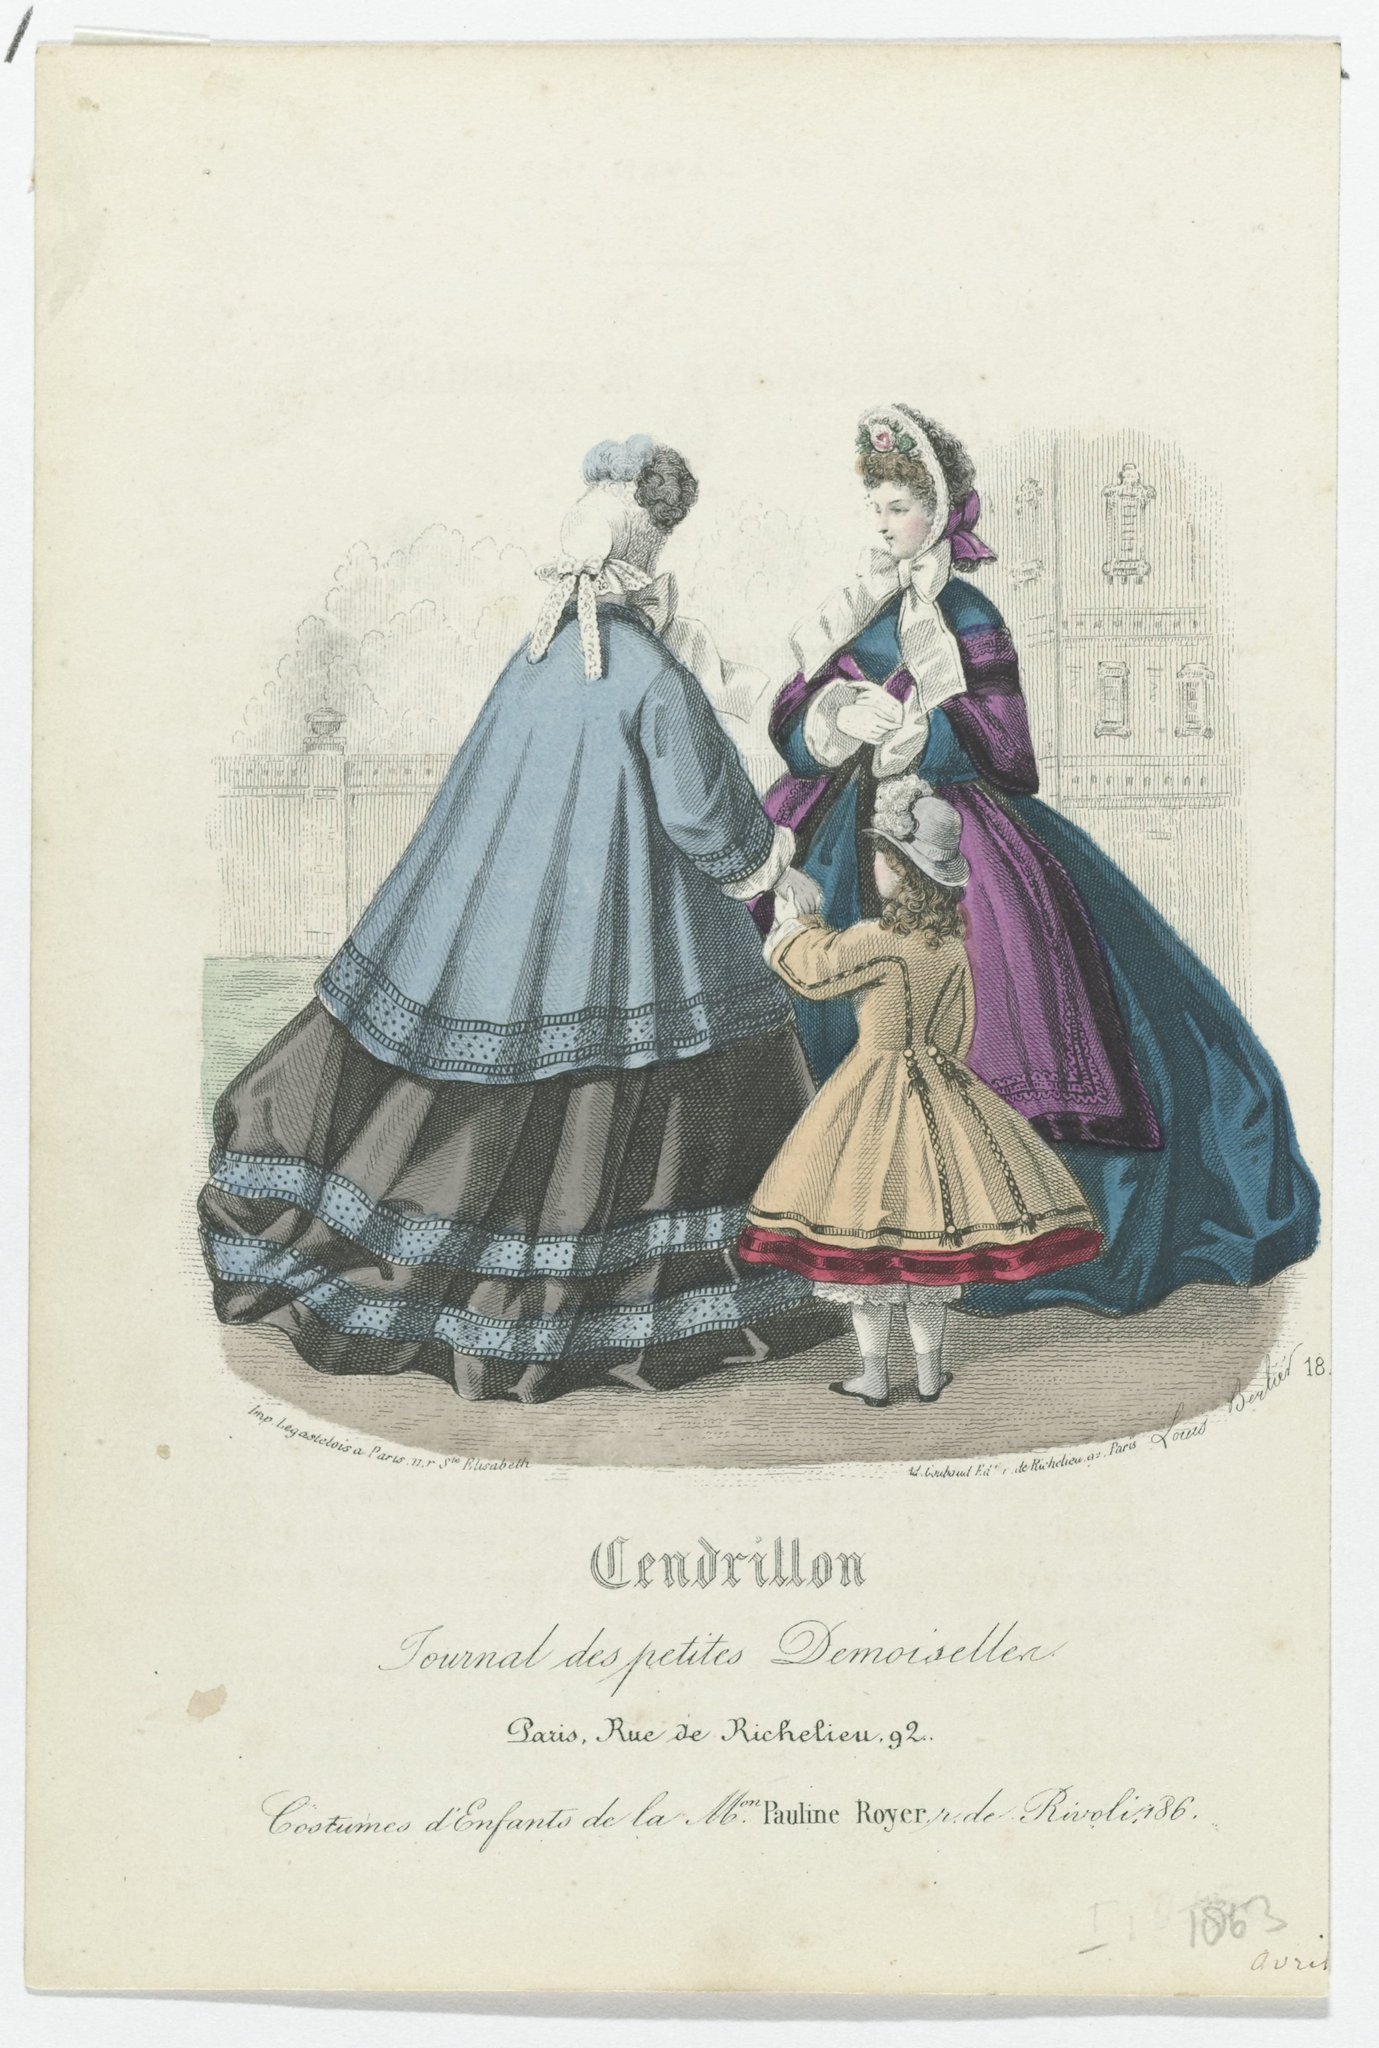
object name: fashion print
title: Cendrillon, avril 1863, No. 18 : Journal des petites Demoiselles...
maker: louis berlier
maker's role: print maker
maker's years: 1825-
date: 1863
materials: paper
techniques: engraving, hand coloring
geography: paris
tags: clothing for the upper part of the body (shawl) (+ women's clothes), clothes, costume (+ girls' clothes), head-gear: hat (+ girls' clothes), coat (+ women's clothes), fashion plates, head-gear: hat (+ women's clothes), skirt (+ women's clothes)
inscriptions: address: ‘Paris, Rue de Richelieu, 92.’, caption: ‘Costumes d'Enfants de la M.on Pauline Royer, r. de Rivoli, 186.’, title: ‘Cendrillon / Journal des petites Demoiselles’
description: ETwee vrouwen in crinolinejaponnen, in een ommuurde tuin. Volgens het onderschrift: kinderkleding van Pauline Royer. Prent uit het modetijdschrift Cendrillon (1850-1872).